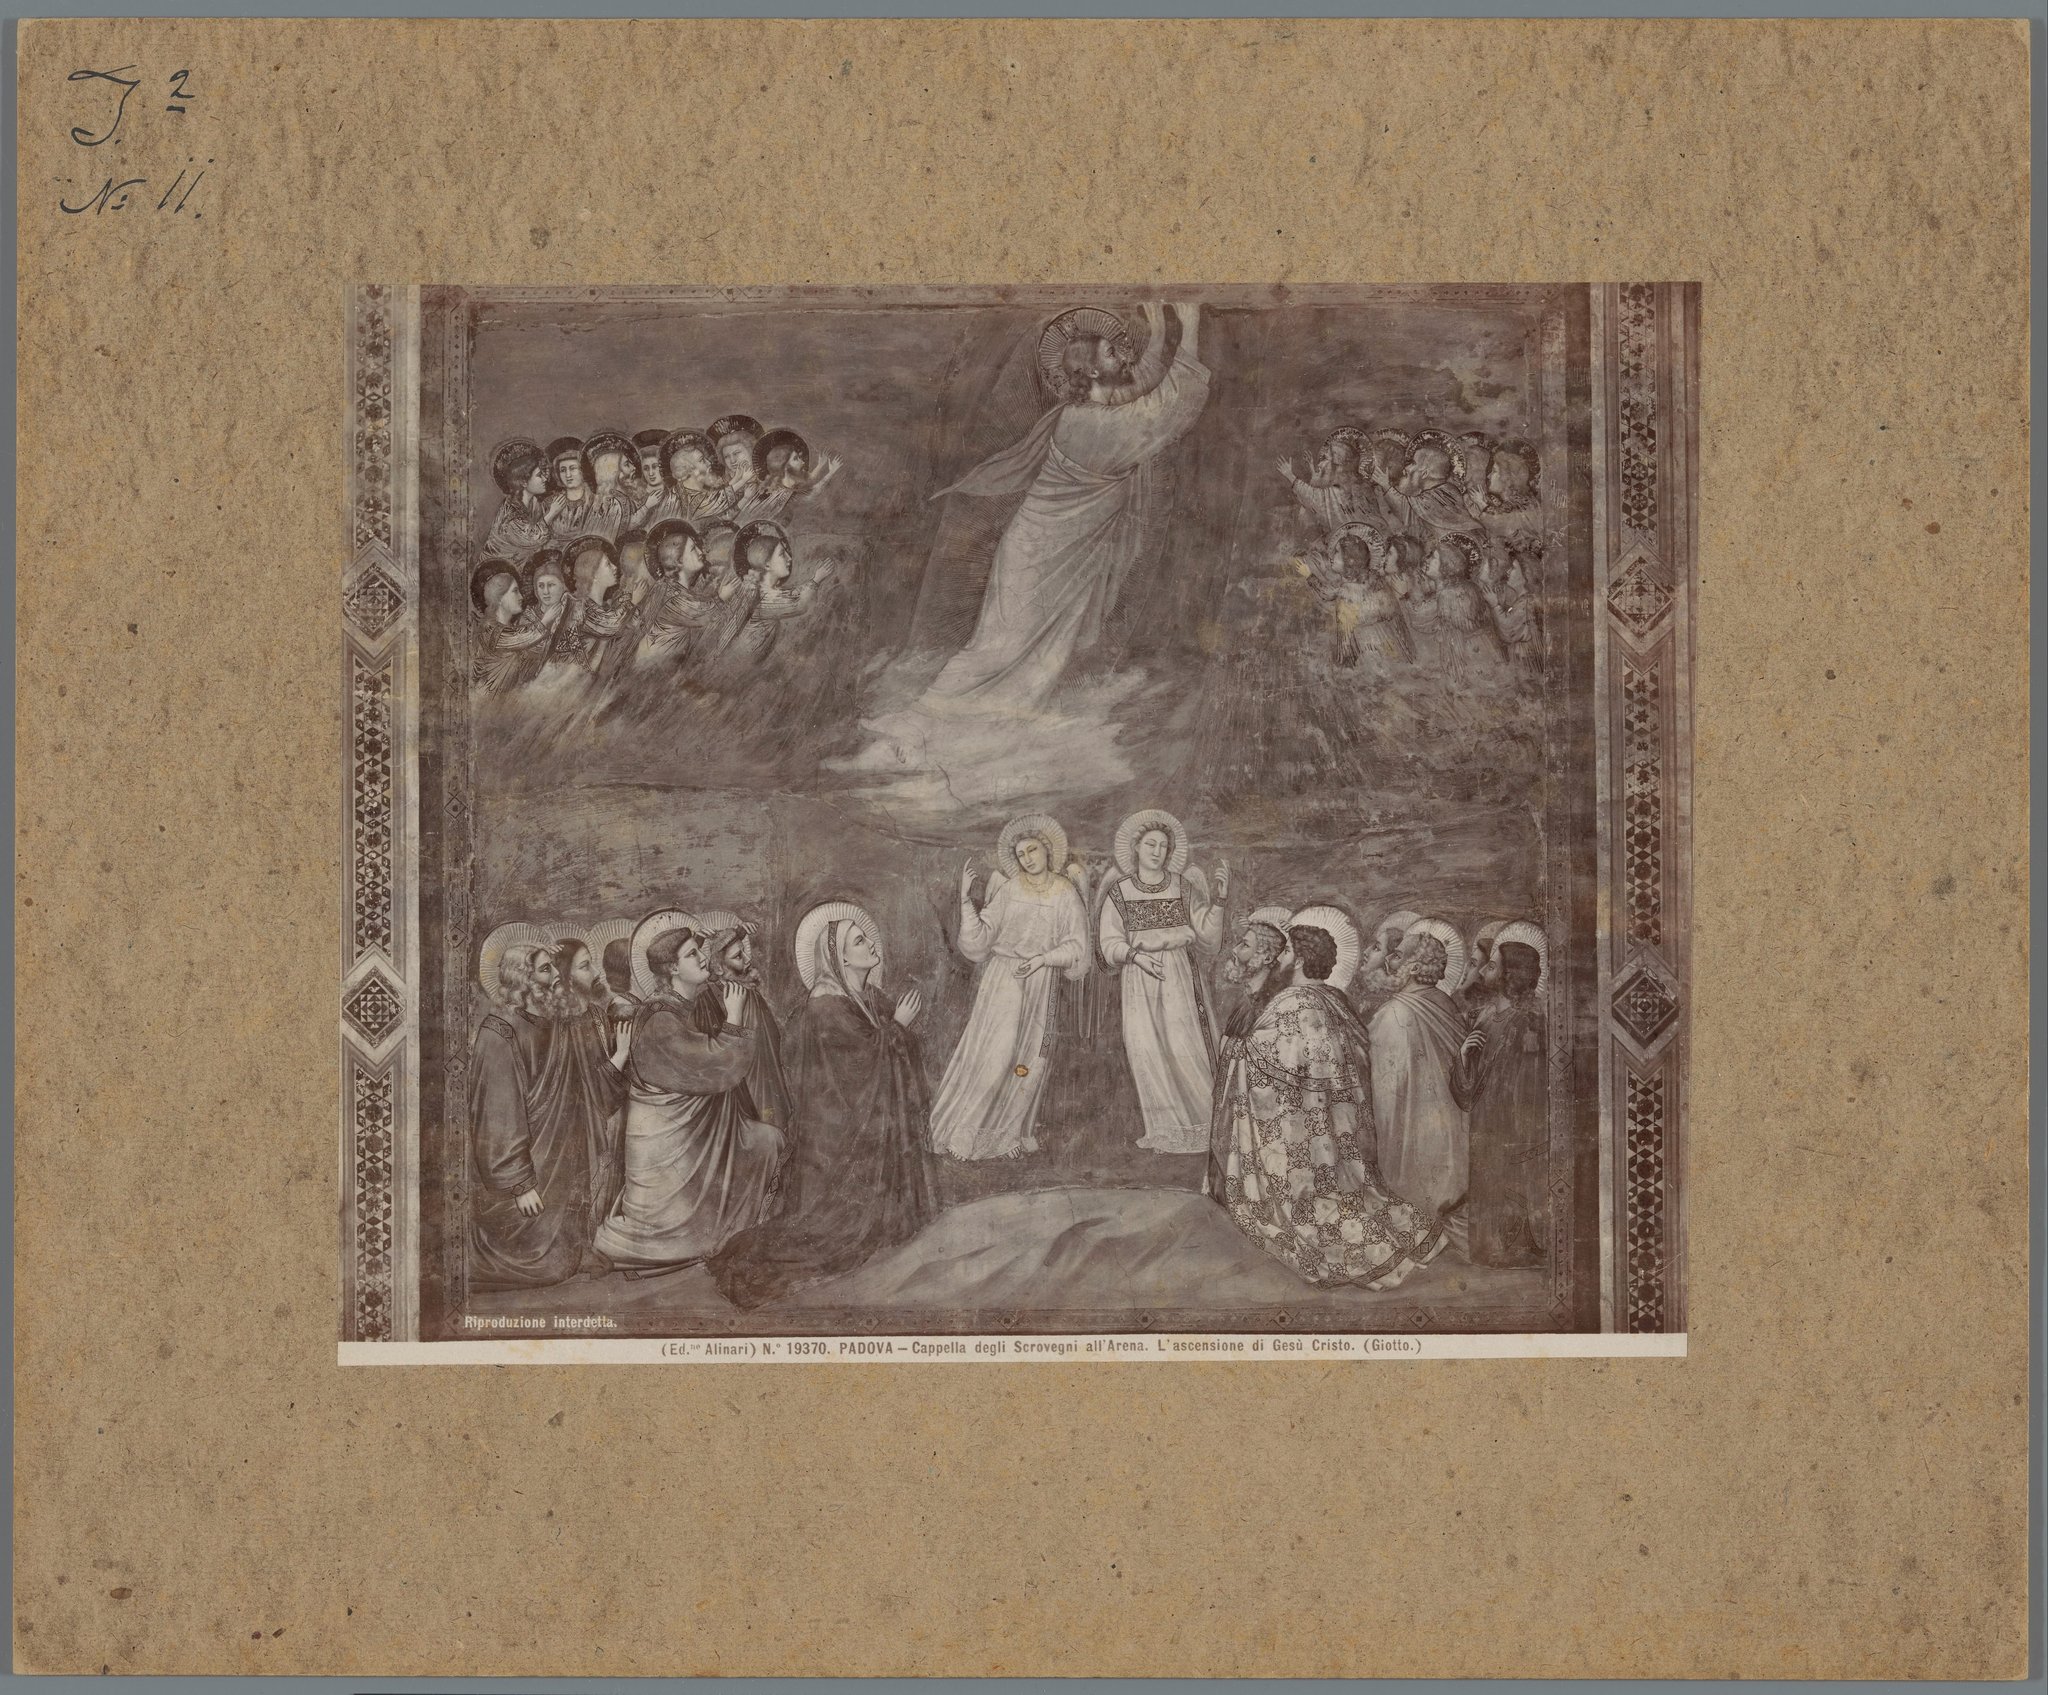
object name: photograph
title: Fotoreproductie van een schildering door Giotto, voorstellende de hemelvaart van Christus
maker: giotto de bondone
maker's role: painter, sculptor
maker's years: 1266-1337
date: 1875-1900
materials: cardboard, photographic support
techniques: albumen print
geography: scrovegnikapel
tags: christ taken up by a cloud ~ ascension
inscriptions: collector's mark: Lugt 3937, number: ‘P.e 2.a N.o 19370.’